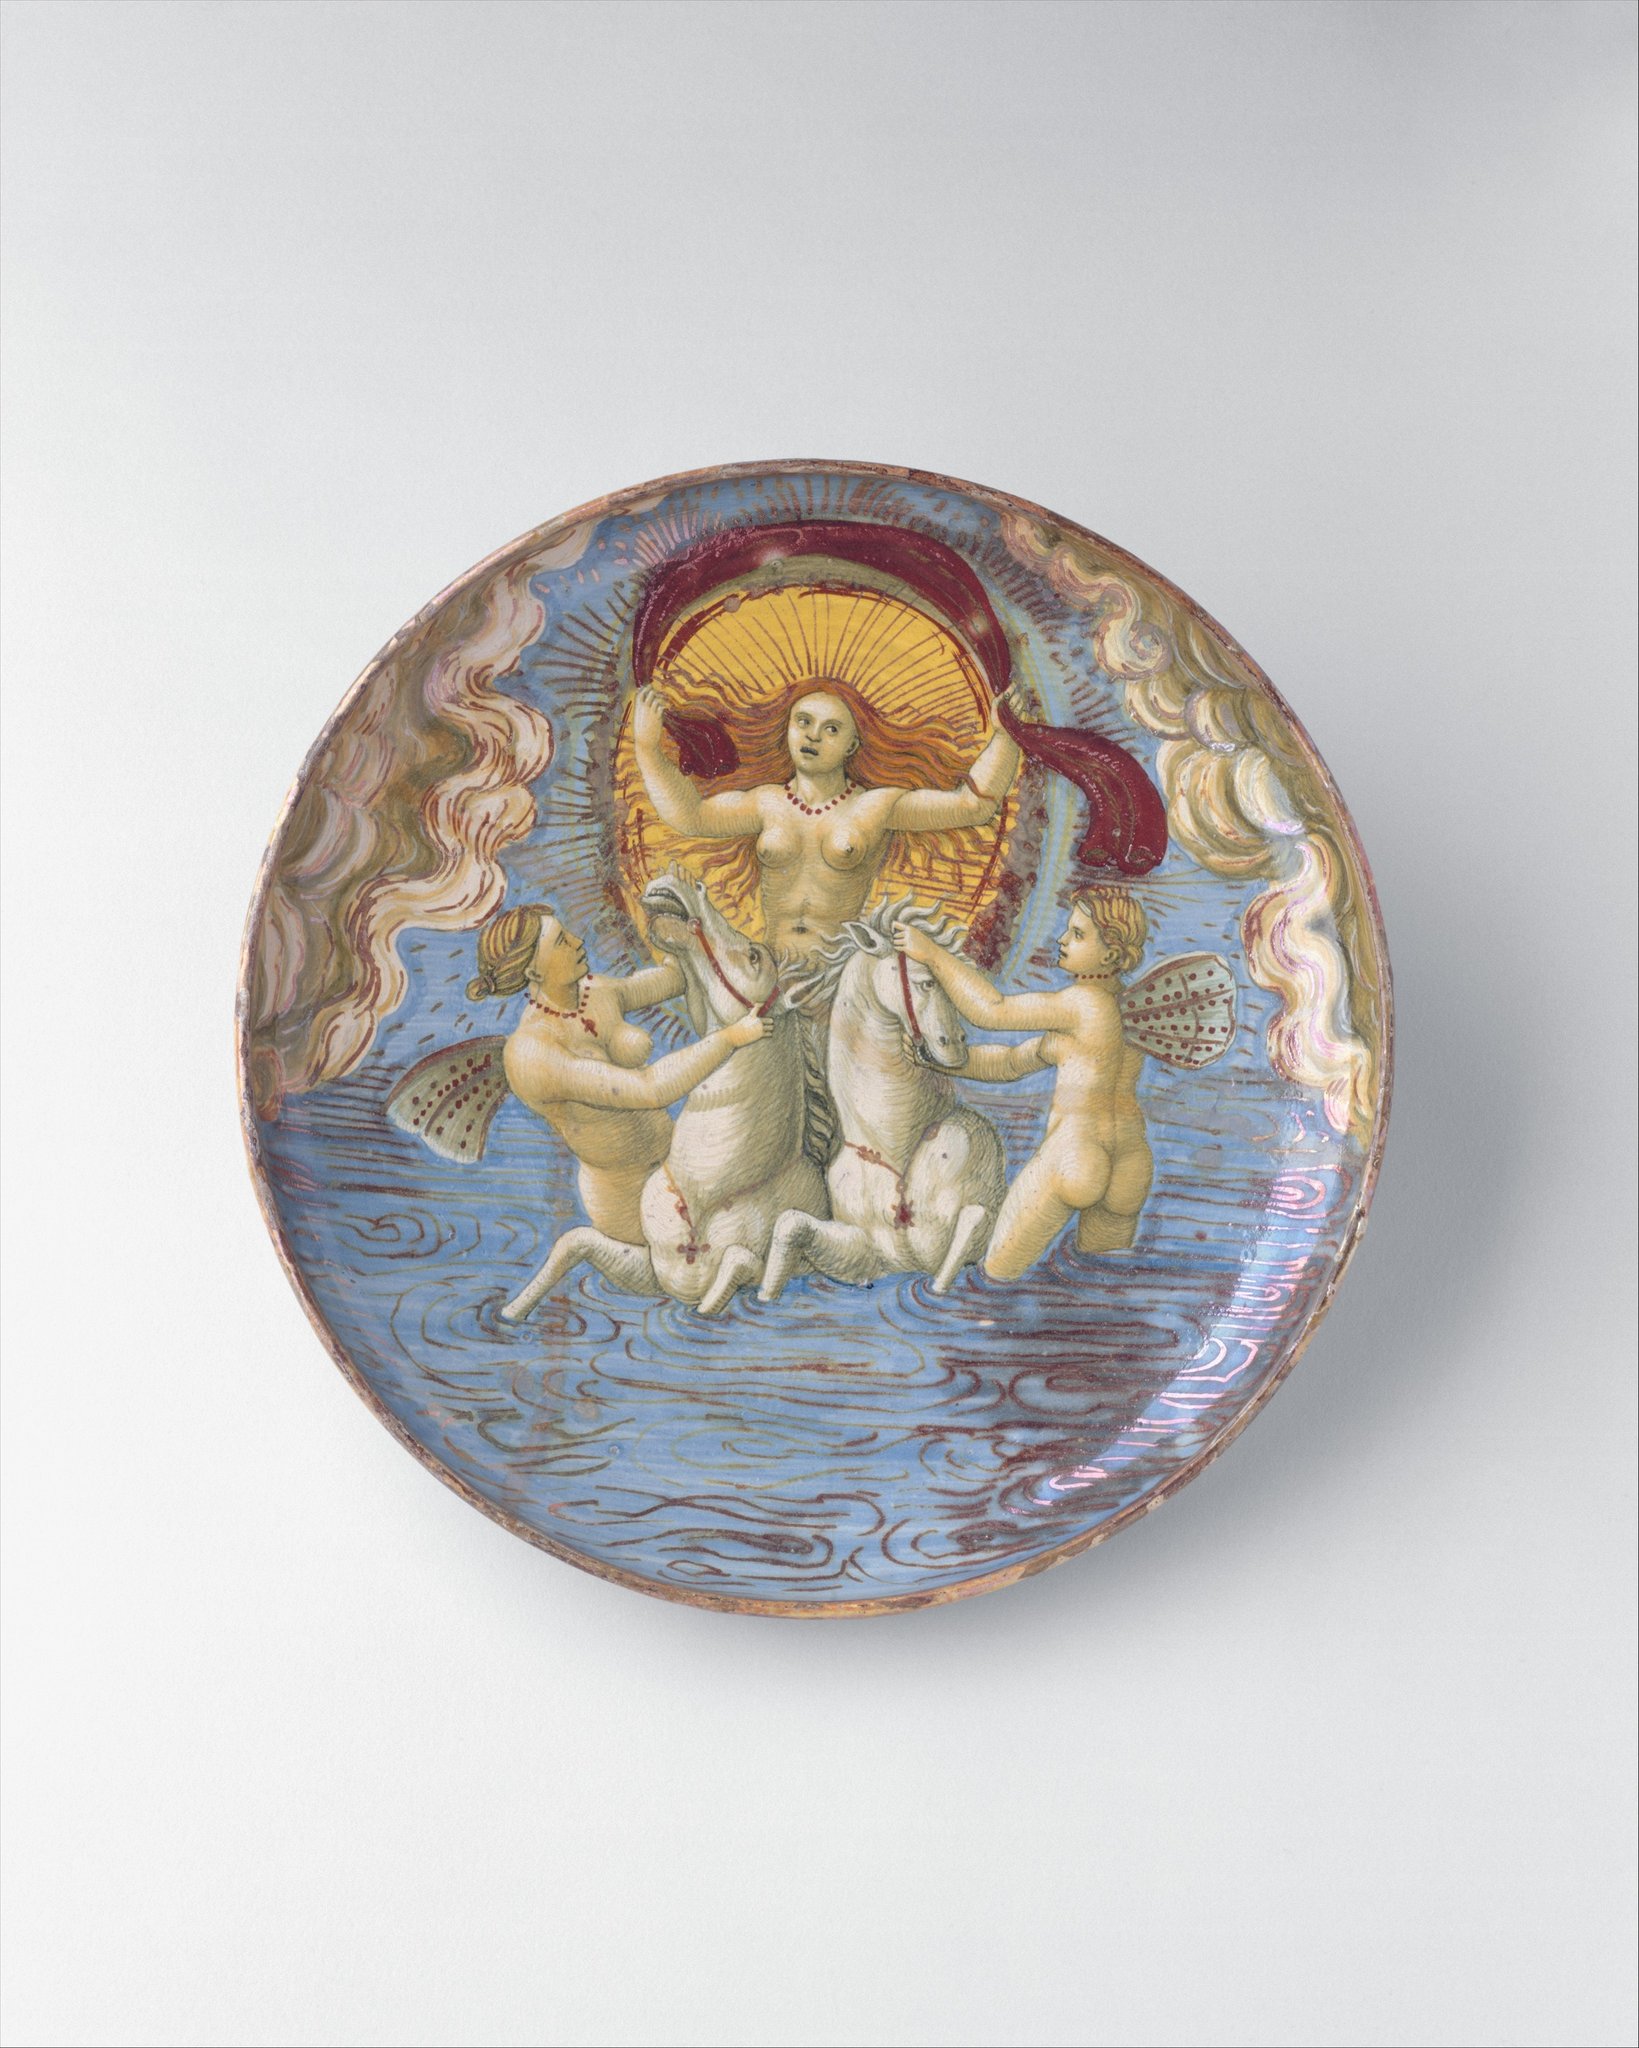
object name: dish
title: Aurora, goddess of dawn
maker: "in castel durante" painter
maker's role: artist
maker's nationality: italian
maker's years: 1500-1550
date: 1528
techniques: maiolica, glazing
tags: female nudes,horses,goddess